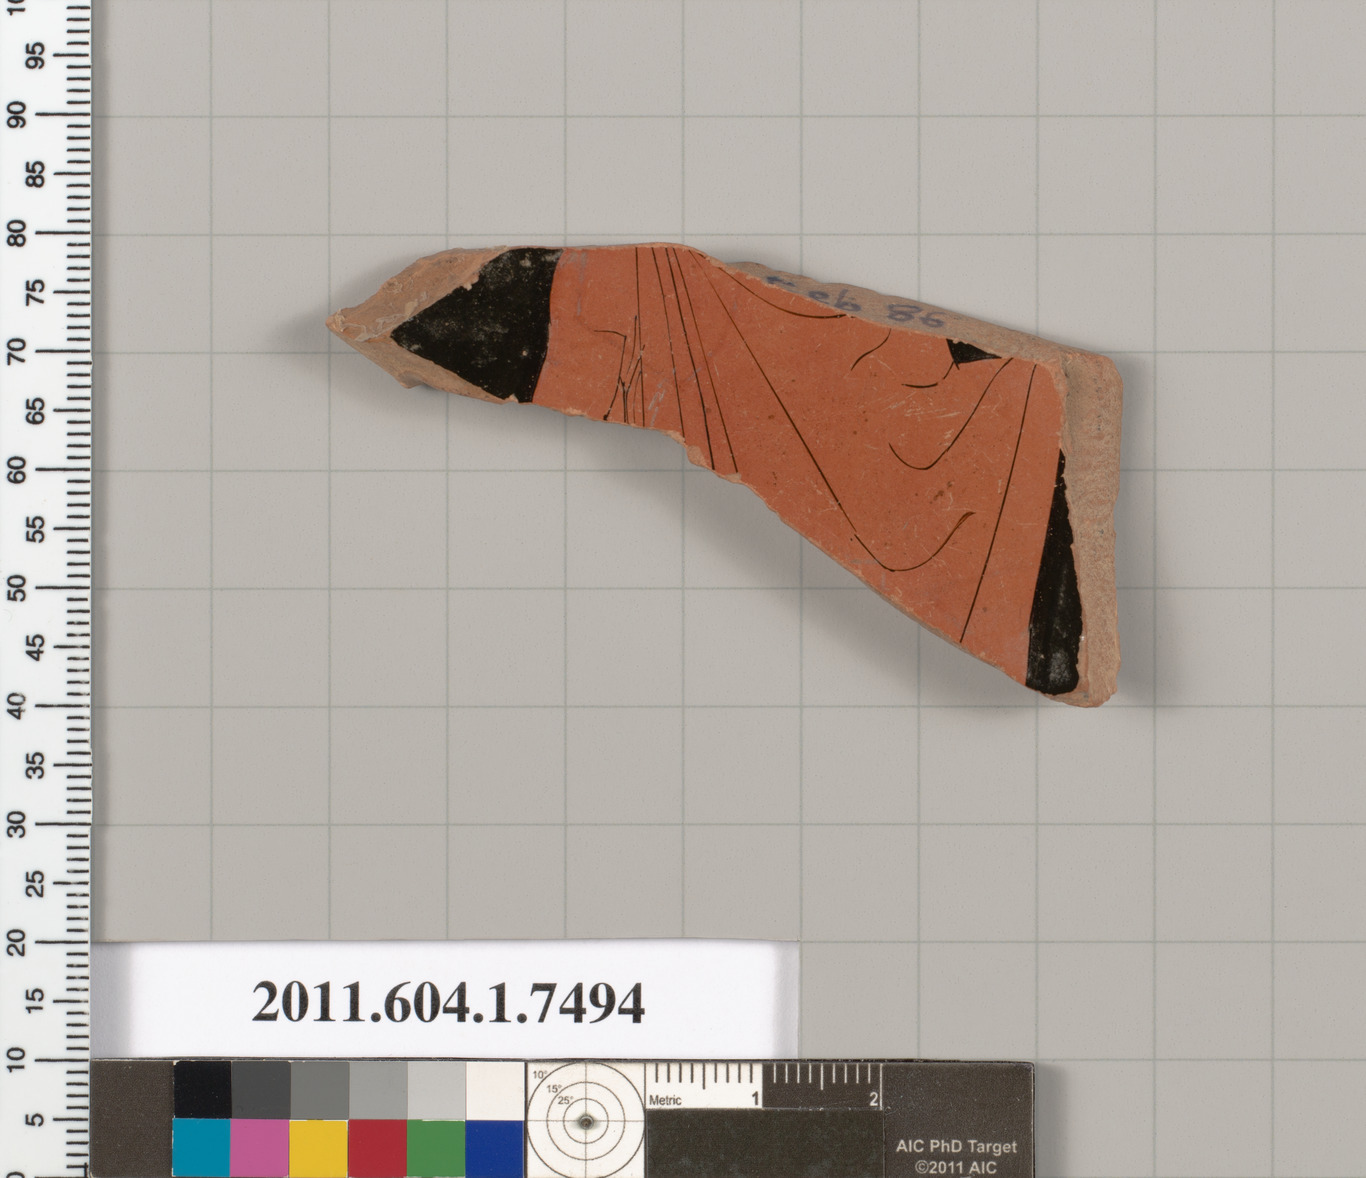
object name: kylix fragment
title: Terracotta fragment of a kylix (drinking cup)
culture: greek, attic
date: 460-450 BCE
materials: terracotta